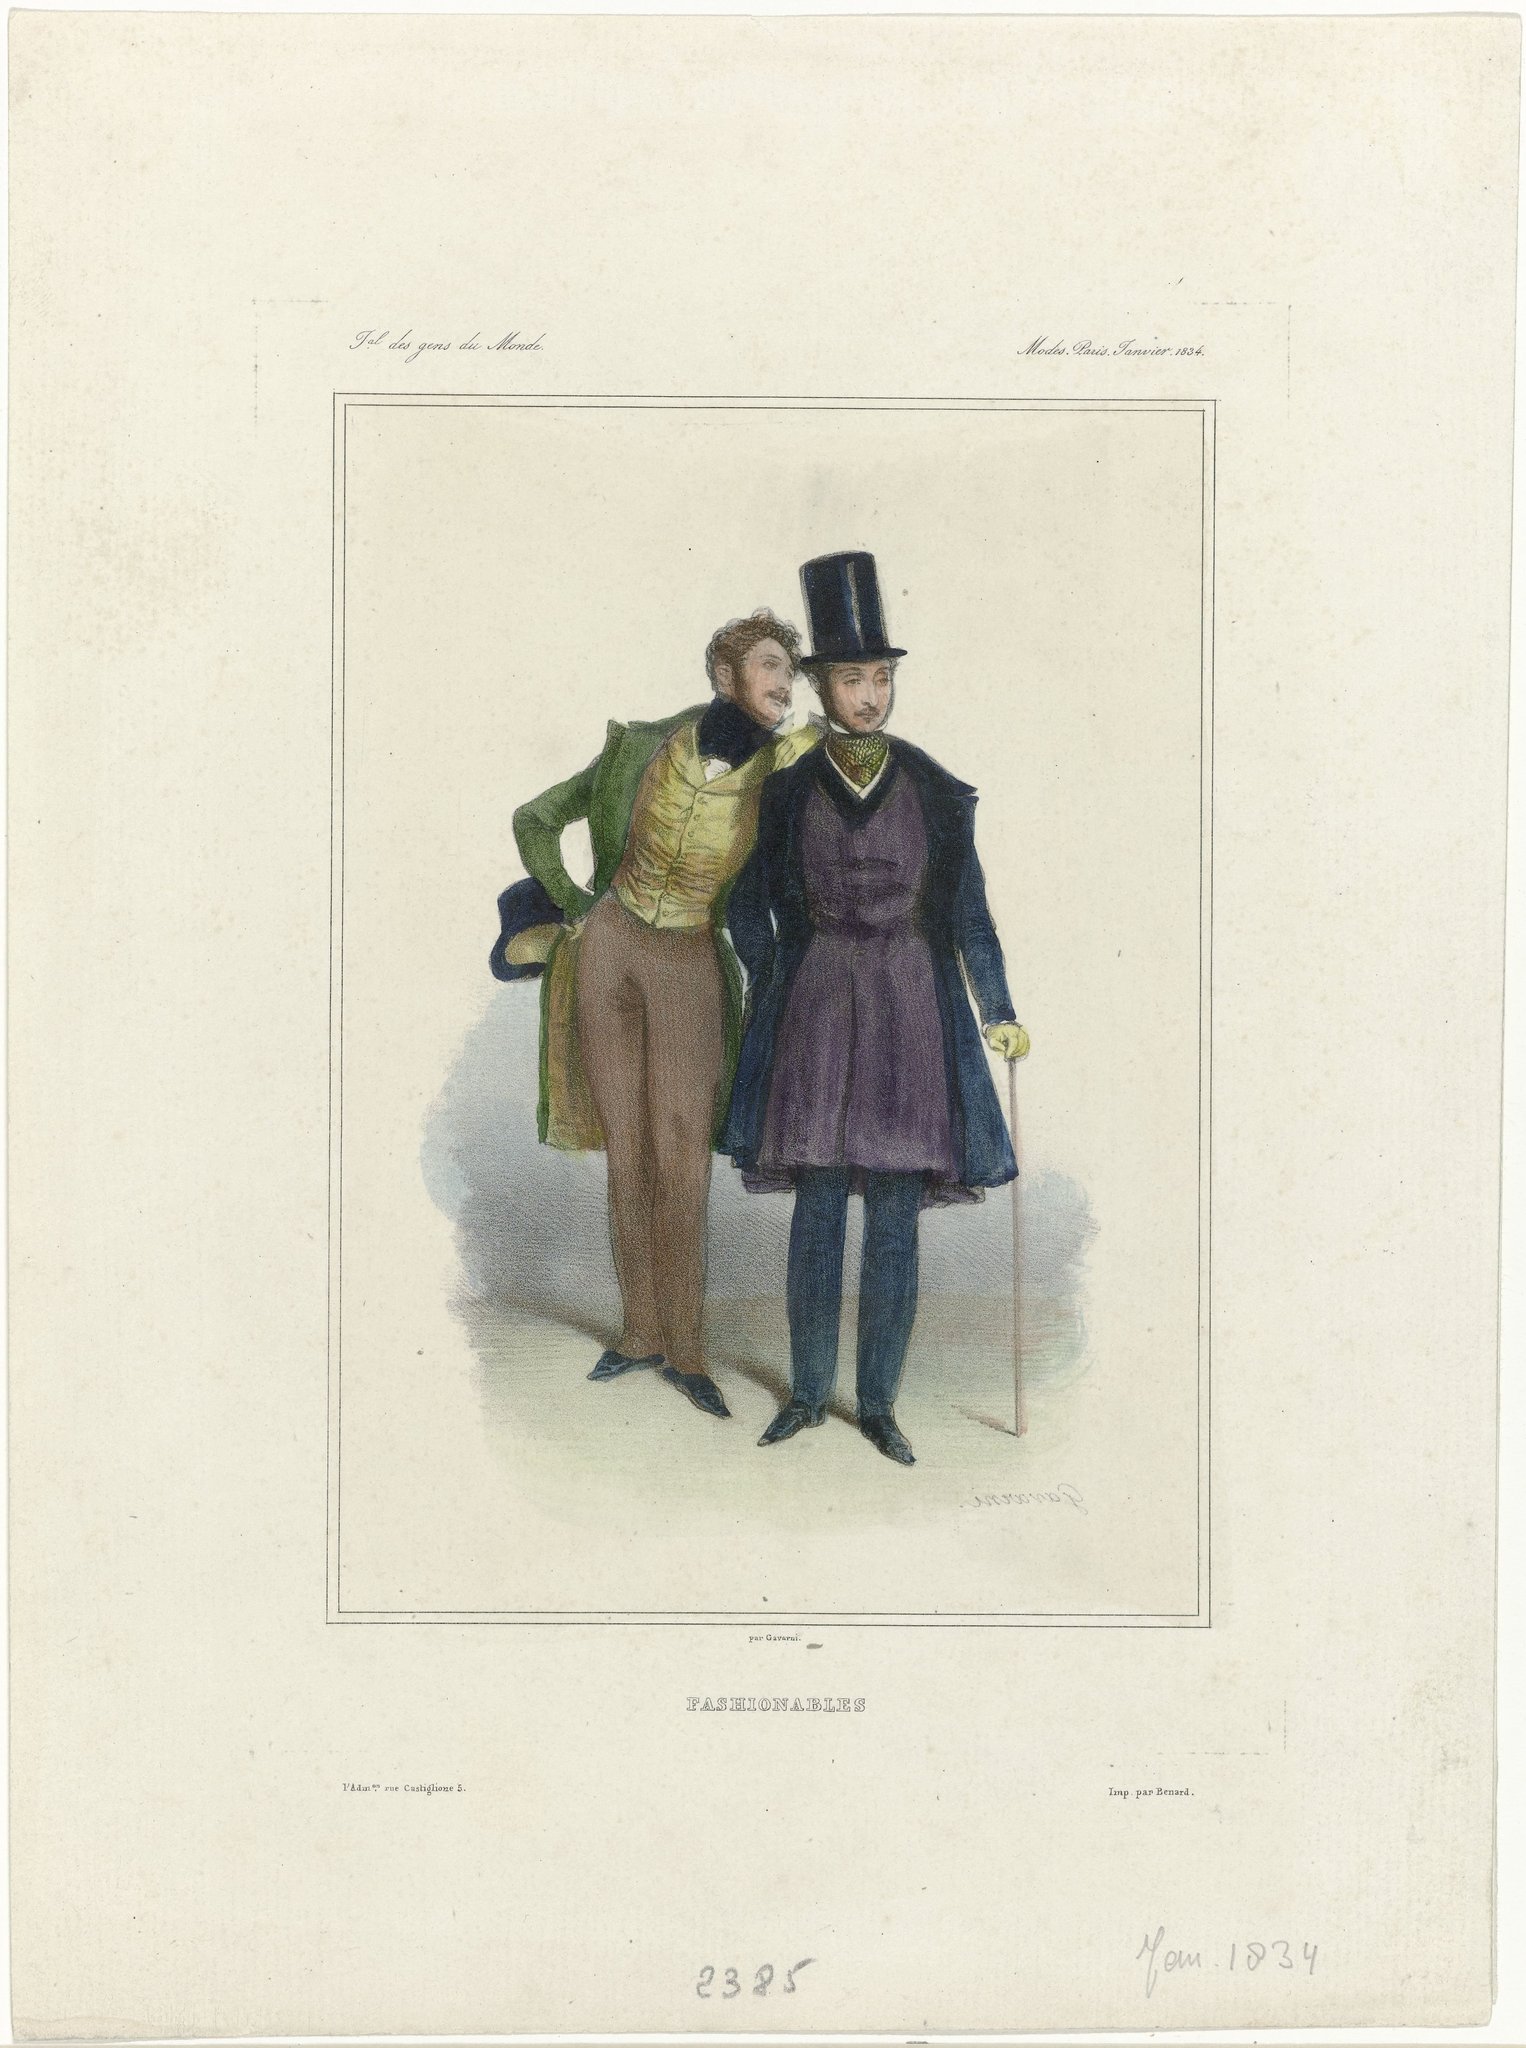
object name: fashion print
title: Journal des Gens du Monde, Modes Paris, janvier 1834 : Fashionables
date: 1834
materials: paper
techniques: hand coloring, lithograph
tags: clothing for the upper part of the body (vest) (+ men's clothes), neck-gear ~ clothing (+ men's clothes), trousers, breeches, etc. (pantalon) (+ men's clothes), coat (+ men's clothes), fashion plates, shoes, sandals (+ men's clothes), walking-stick, staff, cane (+ men's clothes)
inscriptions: address: ‘l'Adm.on rue Castiglione 5.’, caption: ‘Fashionables’, title: ‘J.al des Gens du Monde. / Modes. Janvier. 1834.’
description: Twee modieuze mannen. Beiden gekleed in een fas, vest en spanbroek. Geknoopte halsdoek. Accessoires: hoge hoed, handschoenen, wandelstok. Prent uit het modetijdschrift Journal des Gens du Monde (6 december 1833- mei 1834).